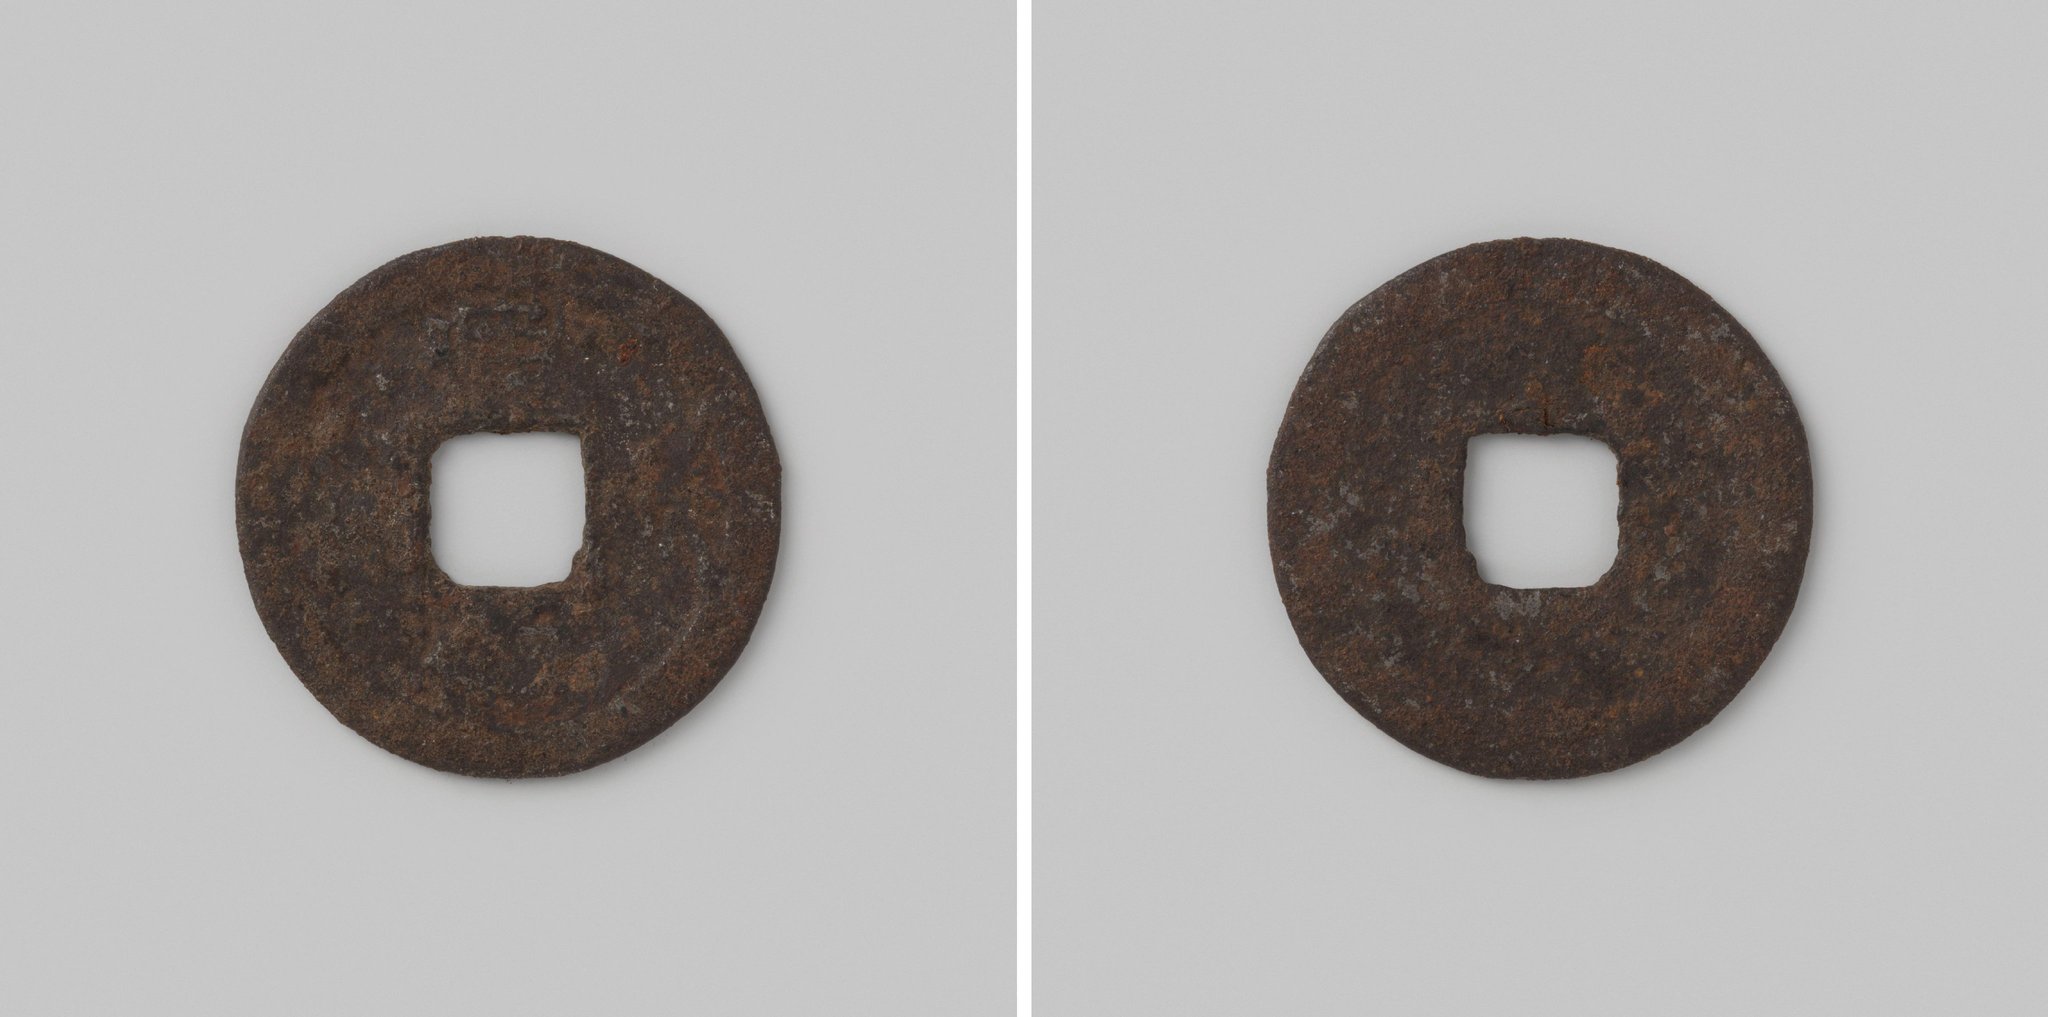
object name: coin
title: Keizerrijk Japan, sen van 1 mon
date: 1739-1868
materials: iron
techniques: casting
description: Ijzeren munt. Voorzijde: binnen brede gladde rand rondom vierkante uitsparing in het midden vier kruisgewijze geplaatste tekens met de betekenis: kanei tsuho [= kanei periode]. Keerzijde: binnen brede gladde rand glad oppervlak.